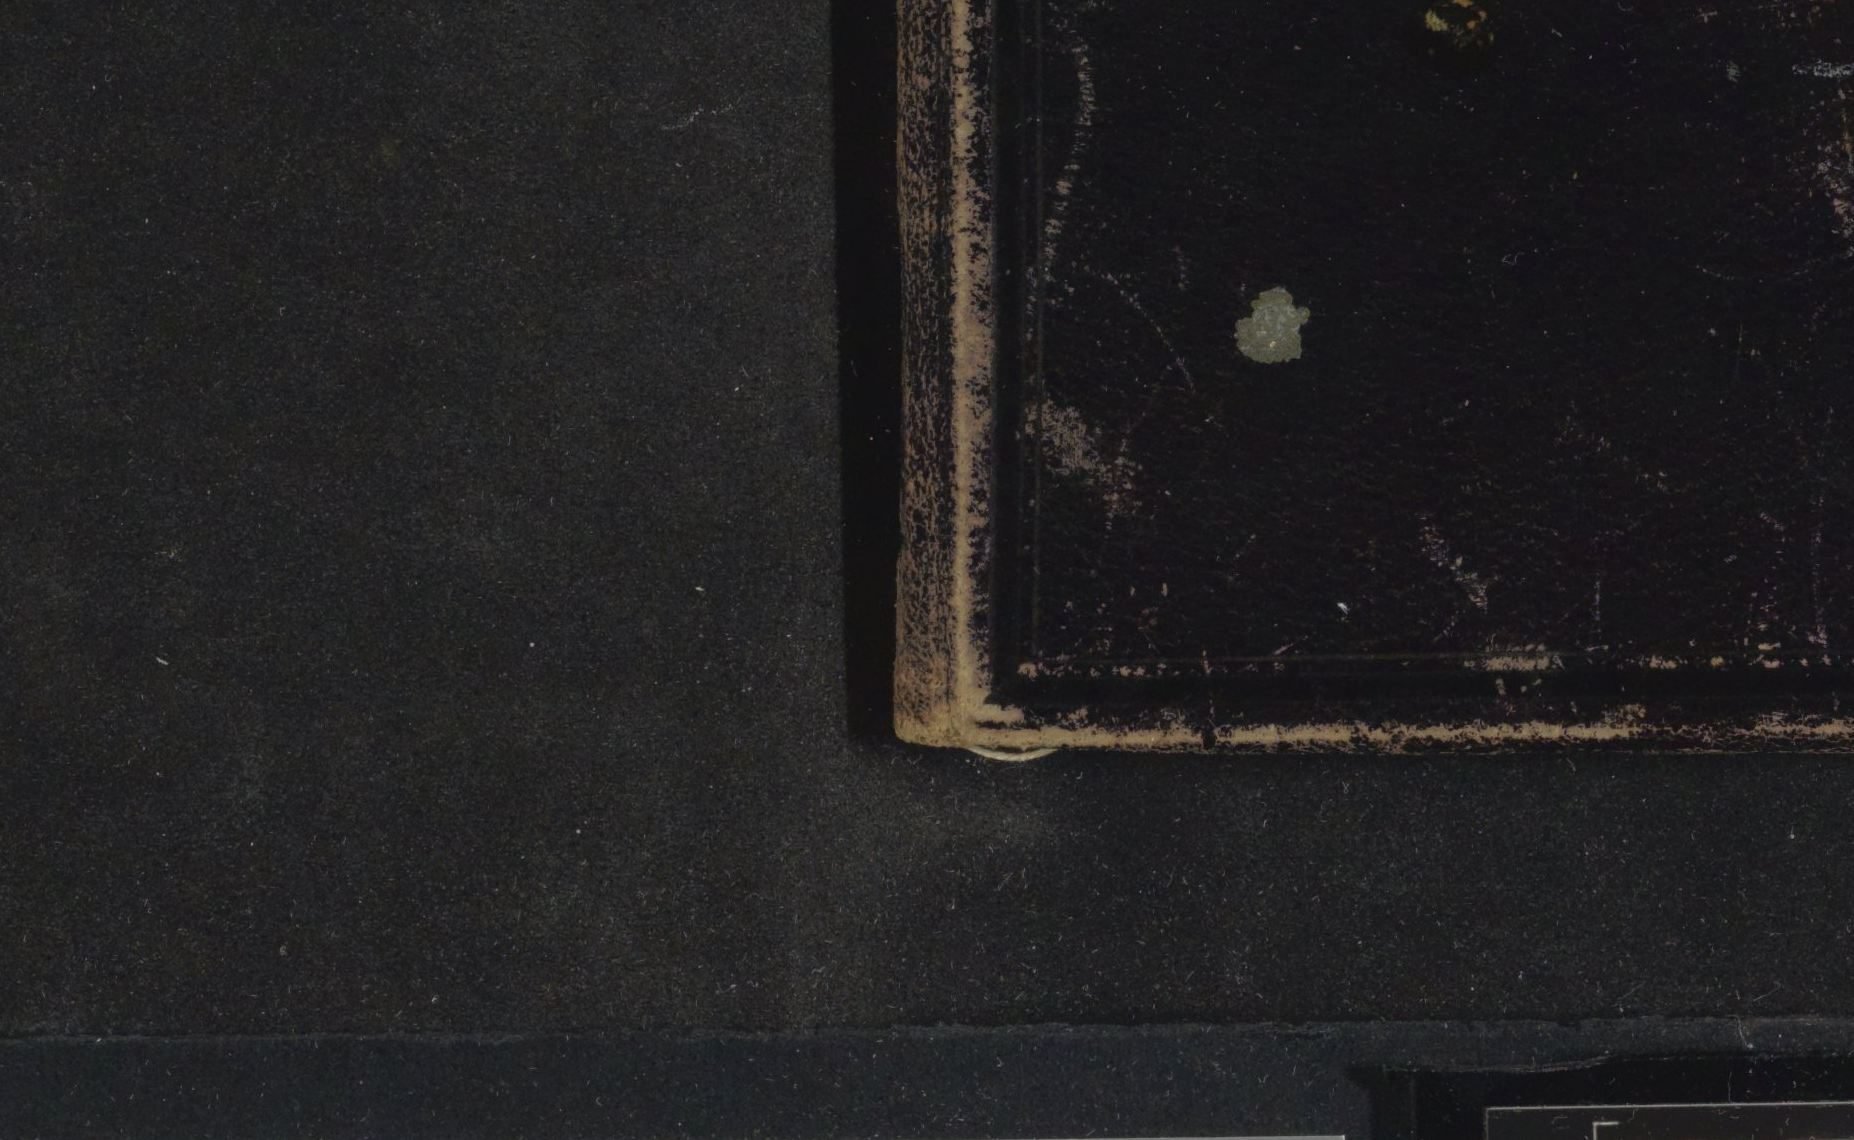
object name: sketchbook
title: Schetsboek met 39 bladen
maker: johan hendrik weissenbruch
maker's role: draughtsman, painter, print maker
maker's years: 1824-1903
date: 1834-1903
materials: cardboard, leather, paper, pencil, watercolor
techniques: brush, stumping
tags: landscapes, anatomy (non-medical)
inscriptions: collector's mark: Lugt 2228a, annotation: ‘Vaas Dick/ 15.2.'43/ Leiden/ Dit is een schetsboekje van Weissenbruch/ m.k.’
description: Schetsboek bestaande uit 39 bladen met voornamelijk figuren, vermoedelijk boeren en landarbeiders, en enkele landschappen.